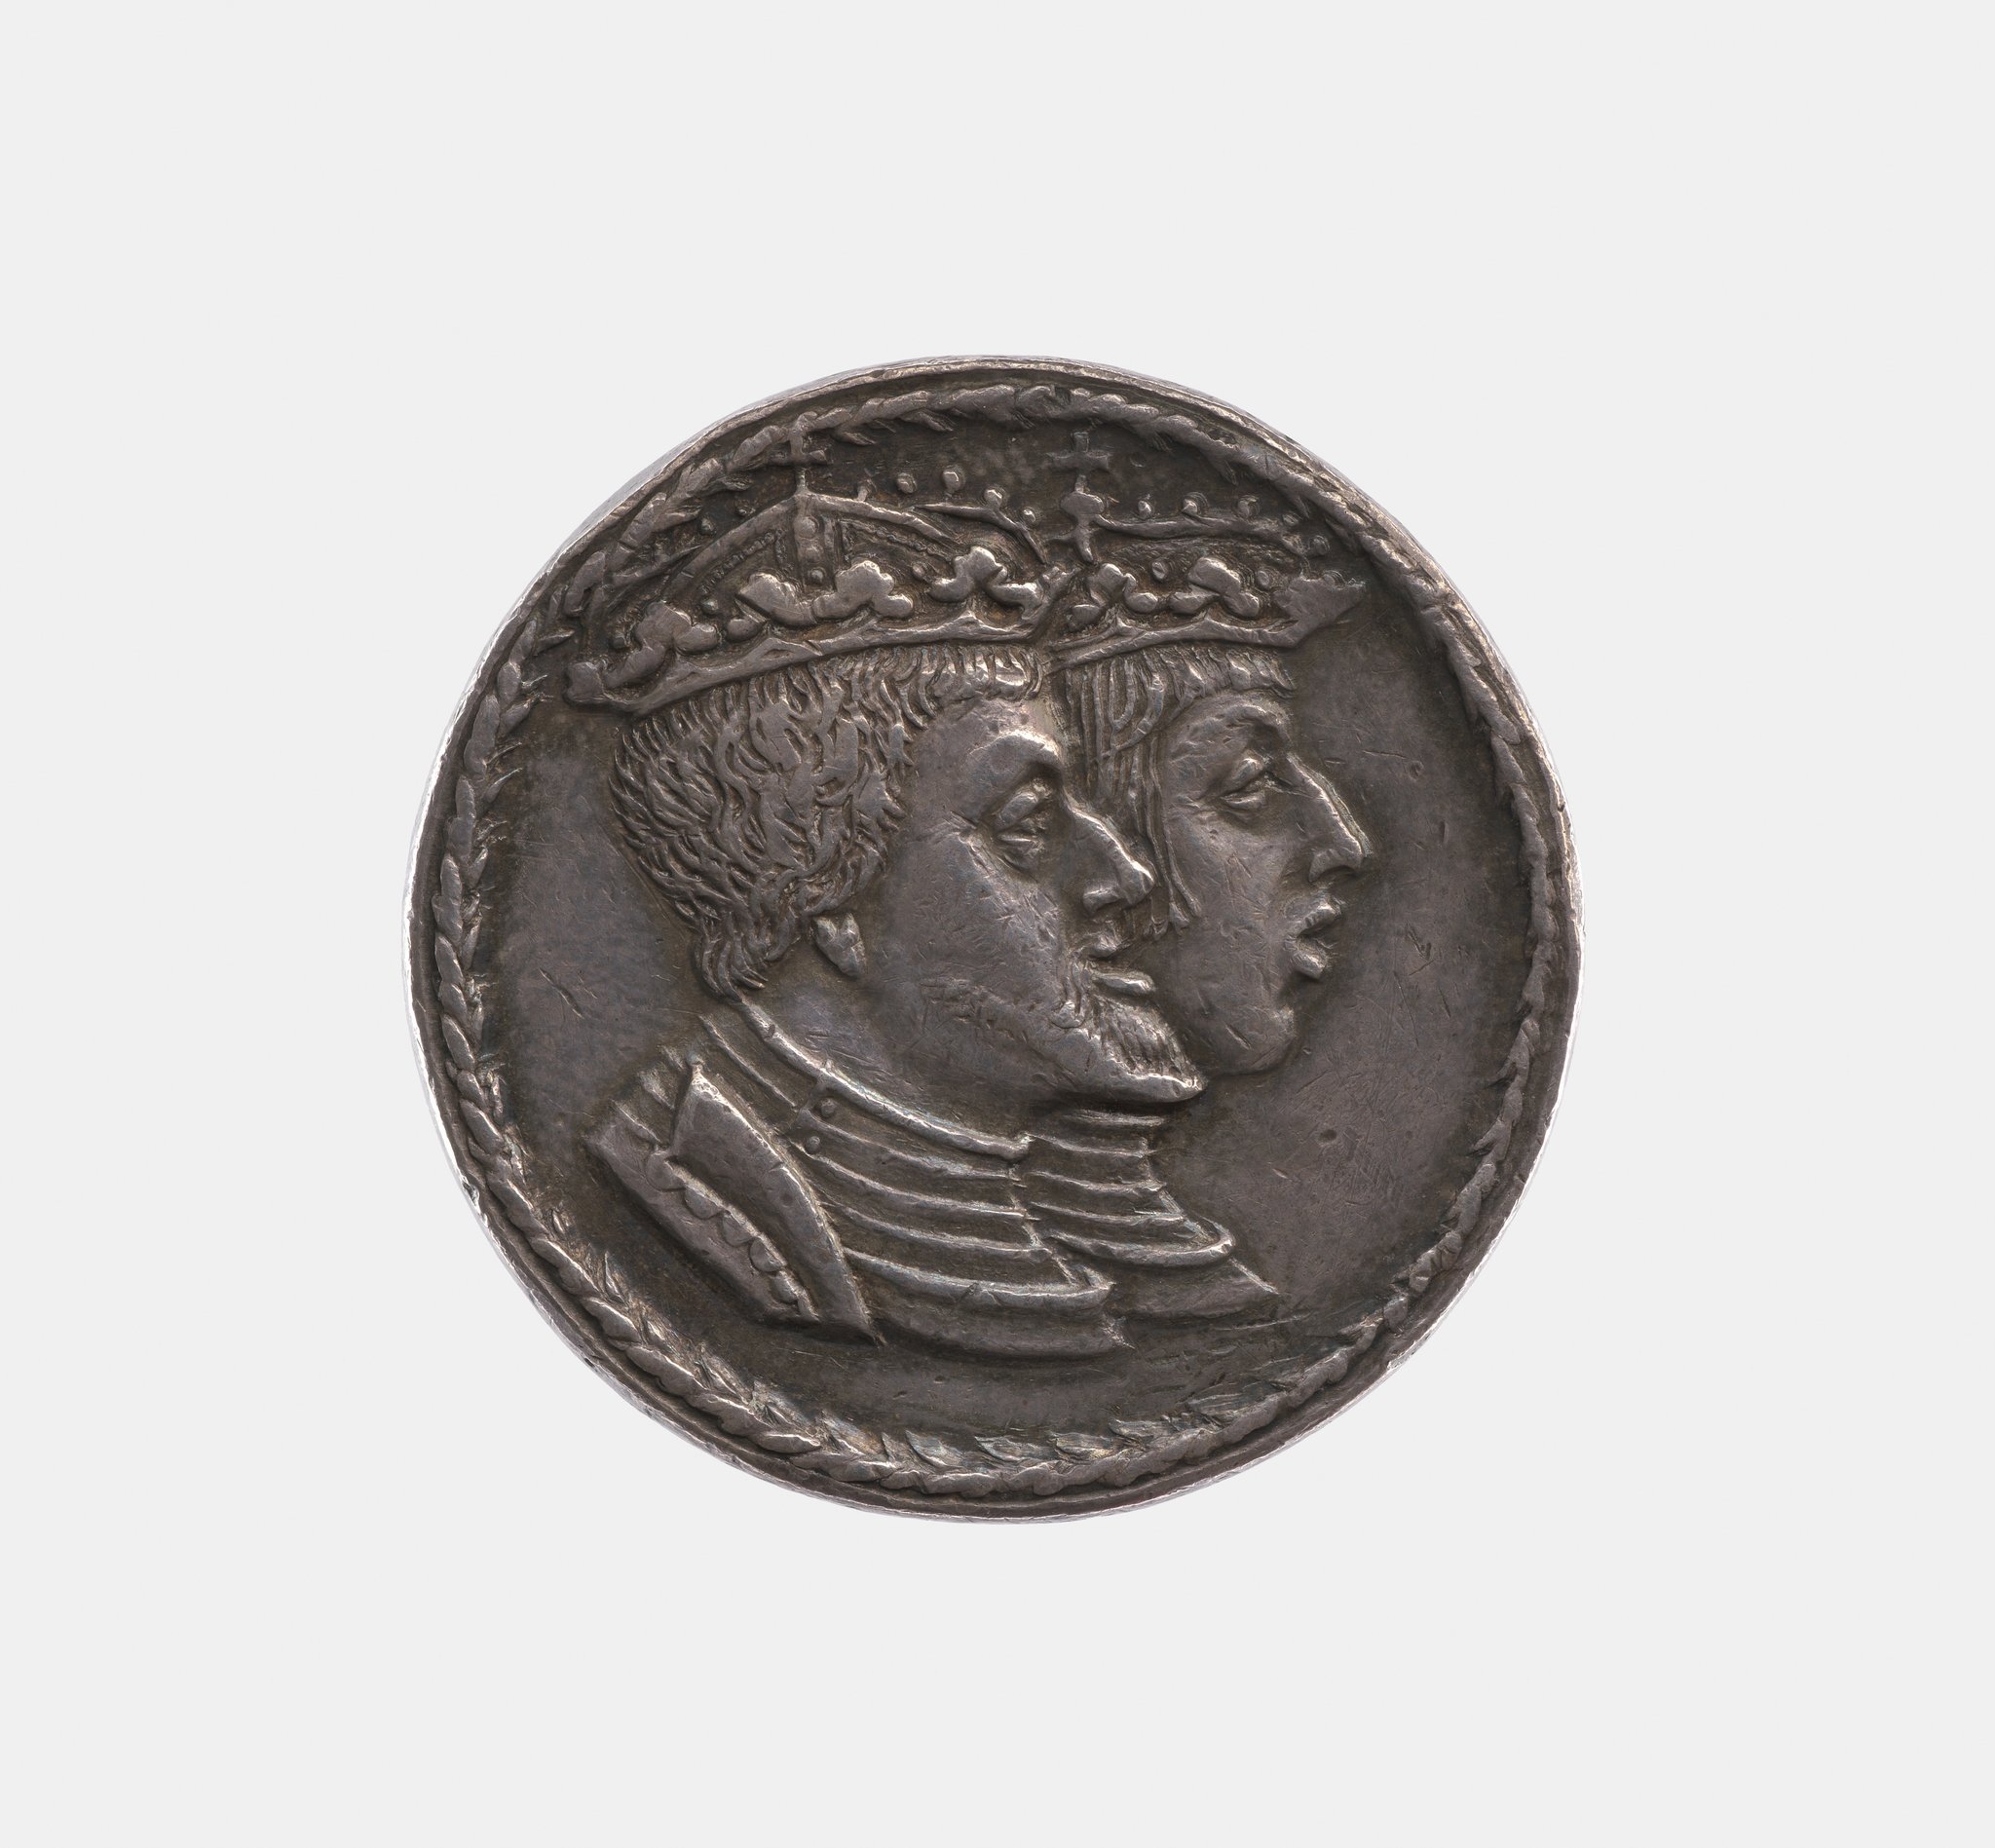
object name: coin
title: Charles V and Fedinand I (Dick-taler)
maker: ulrich ursentaler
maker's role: artist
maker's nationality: austrian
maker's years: 1508-1562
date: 1531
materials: silver